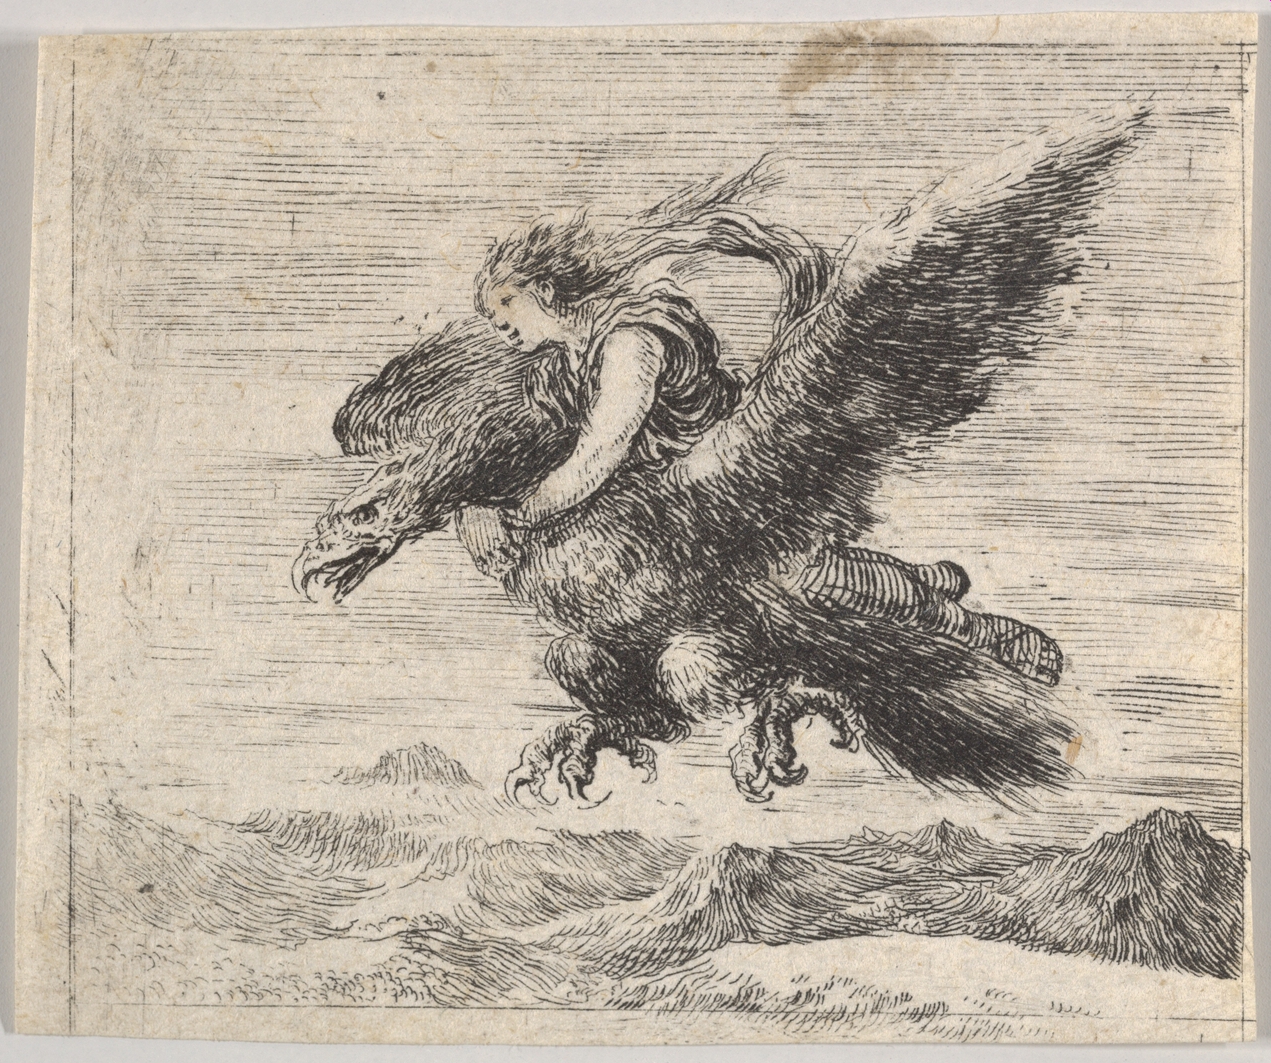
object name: print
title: Jupiter and Ganymede, from "Game of Mythology" (Jeu de la Mythologie)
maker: stefano della bella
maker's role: artist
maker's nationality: italian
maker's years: 1610-1664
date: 1644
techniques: etching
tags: eagles,jupiter